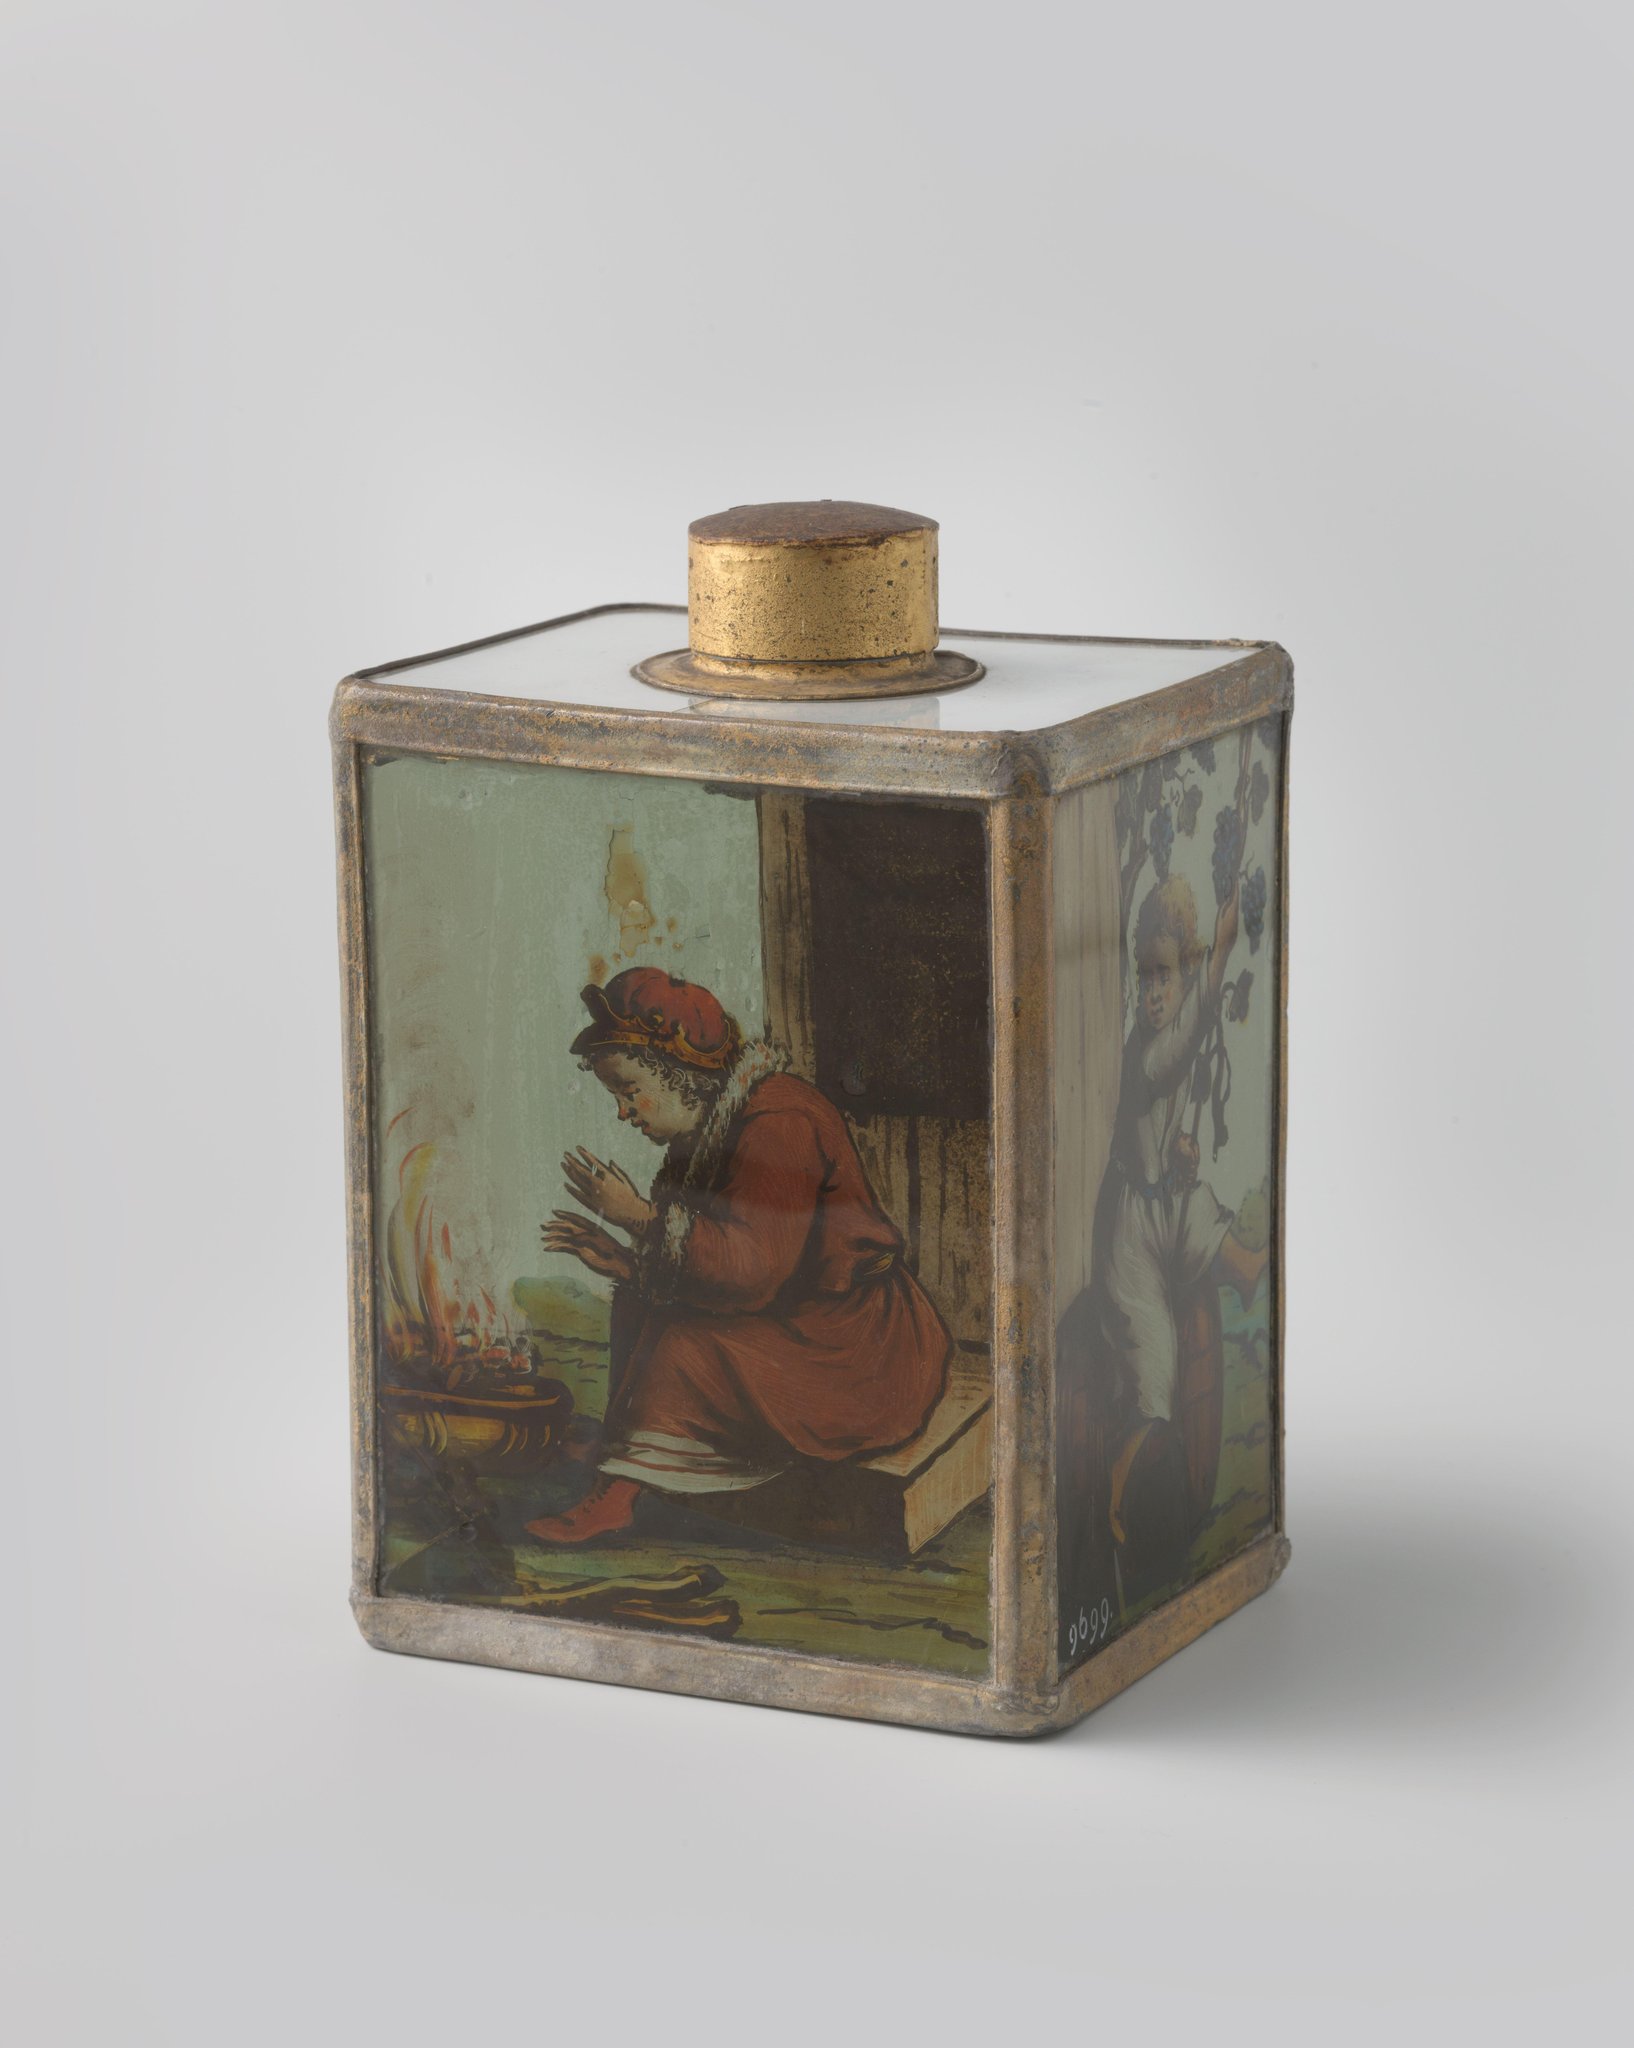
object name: tea caddy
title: Theebus, vierkant, van in lood gevat geschilderd glas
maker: Anonymous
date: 1675-1700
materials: glass, lead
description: Theebus, vierkant, van in lood gevat geschilderd glas (peinture sous verre). Op de zijvakken afbeeldingen van de jaargetijden, voorgesteld door een jonge vrouw of een jongeling met de nodige attributen. Een van de zijvakken gebroken.